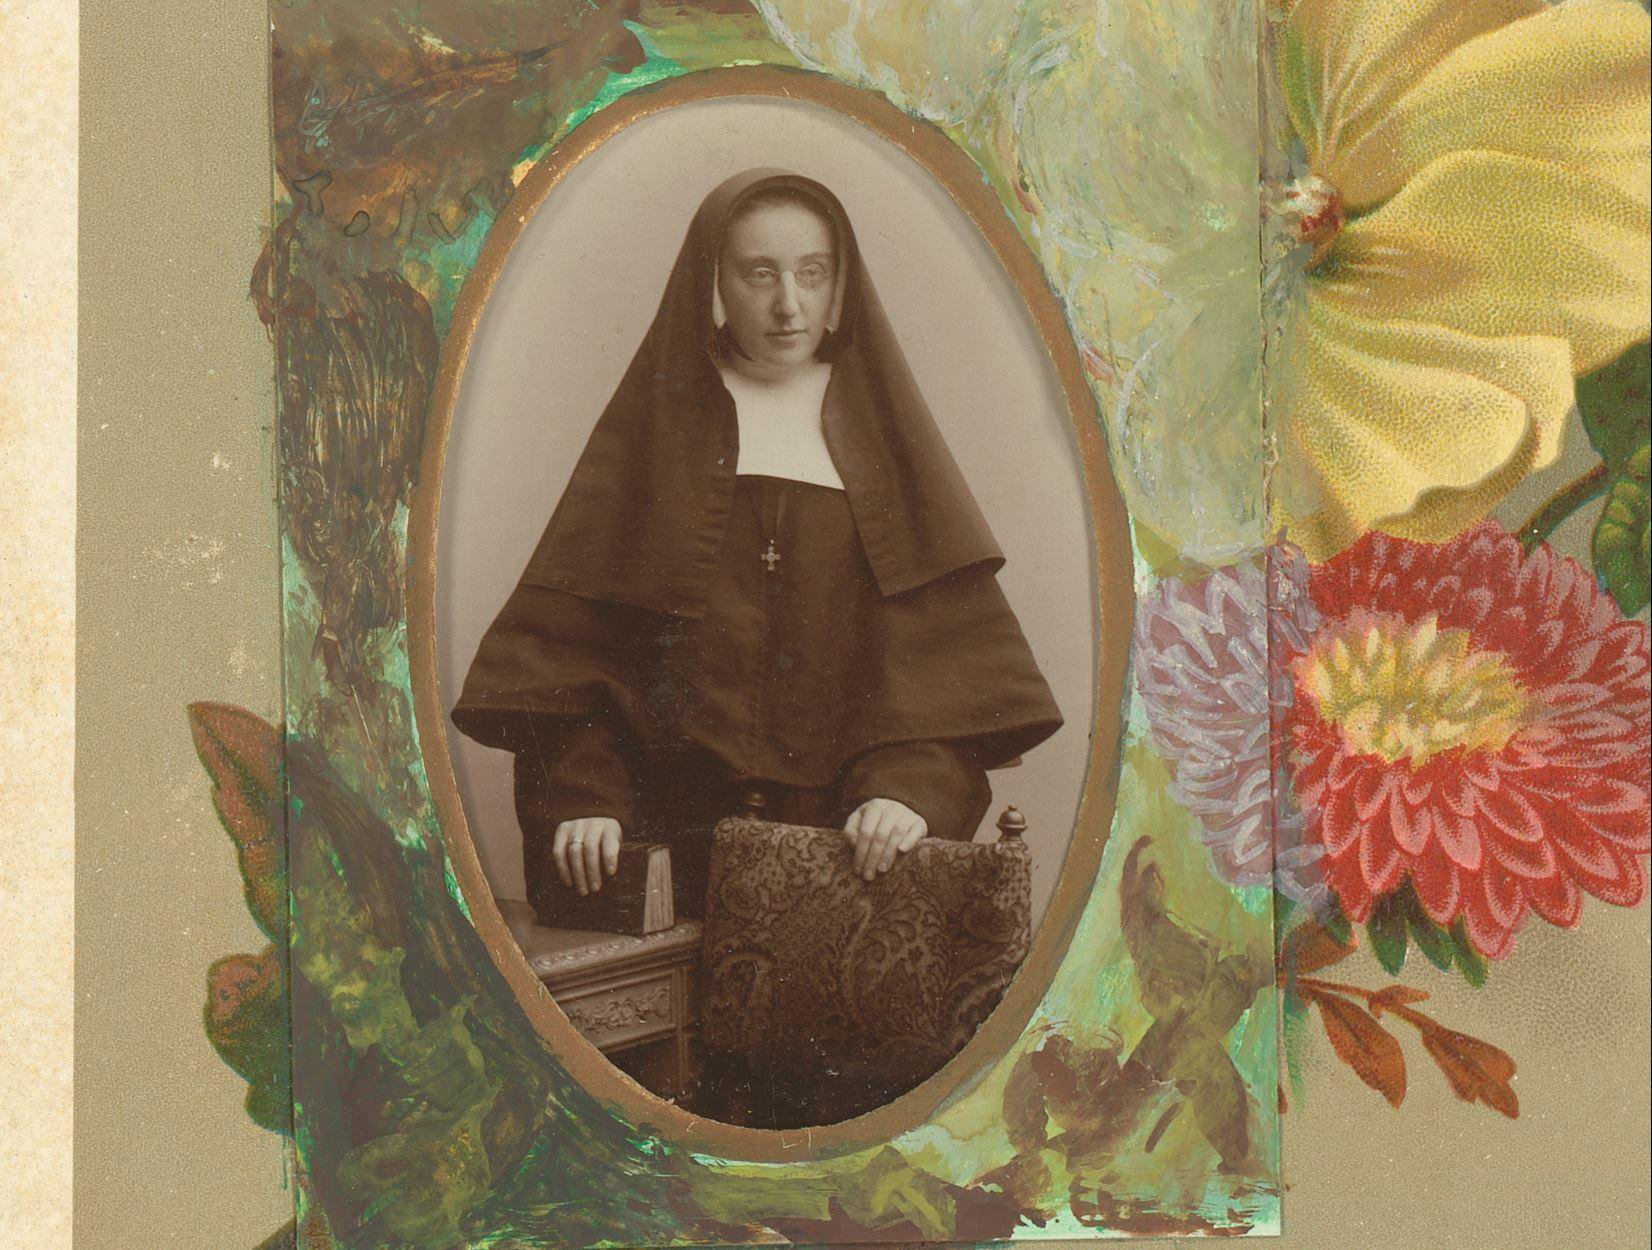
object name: photograph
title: Portret van een jonge begijn met boek in de hand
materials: cardboard, photographic support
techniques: collodion silver print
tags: historical persons - bb - woman, nun(s), book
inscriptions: inscription: ‘(...)/ Photogr. Inrichting/ C. F. Cordes/ 's Bosch/ aan de Parade/ Haarlem, Groote Houtstraat 84./ [Op] verschillende tentoonstellingen bekroond voor Vergrootingen/ in Kooldruk en andere photographien.’